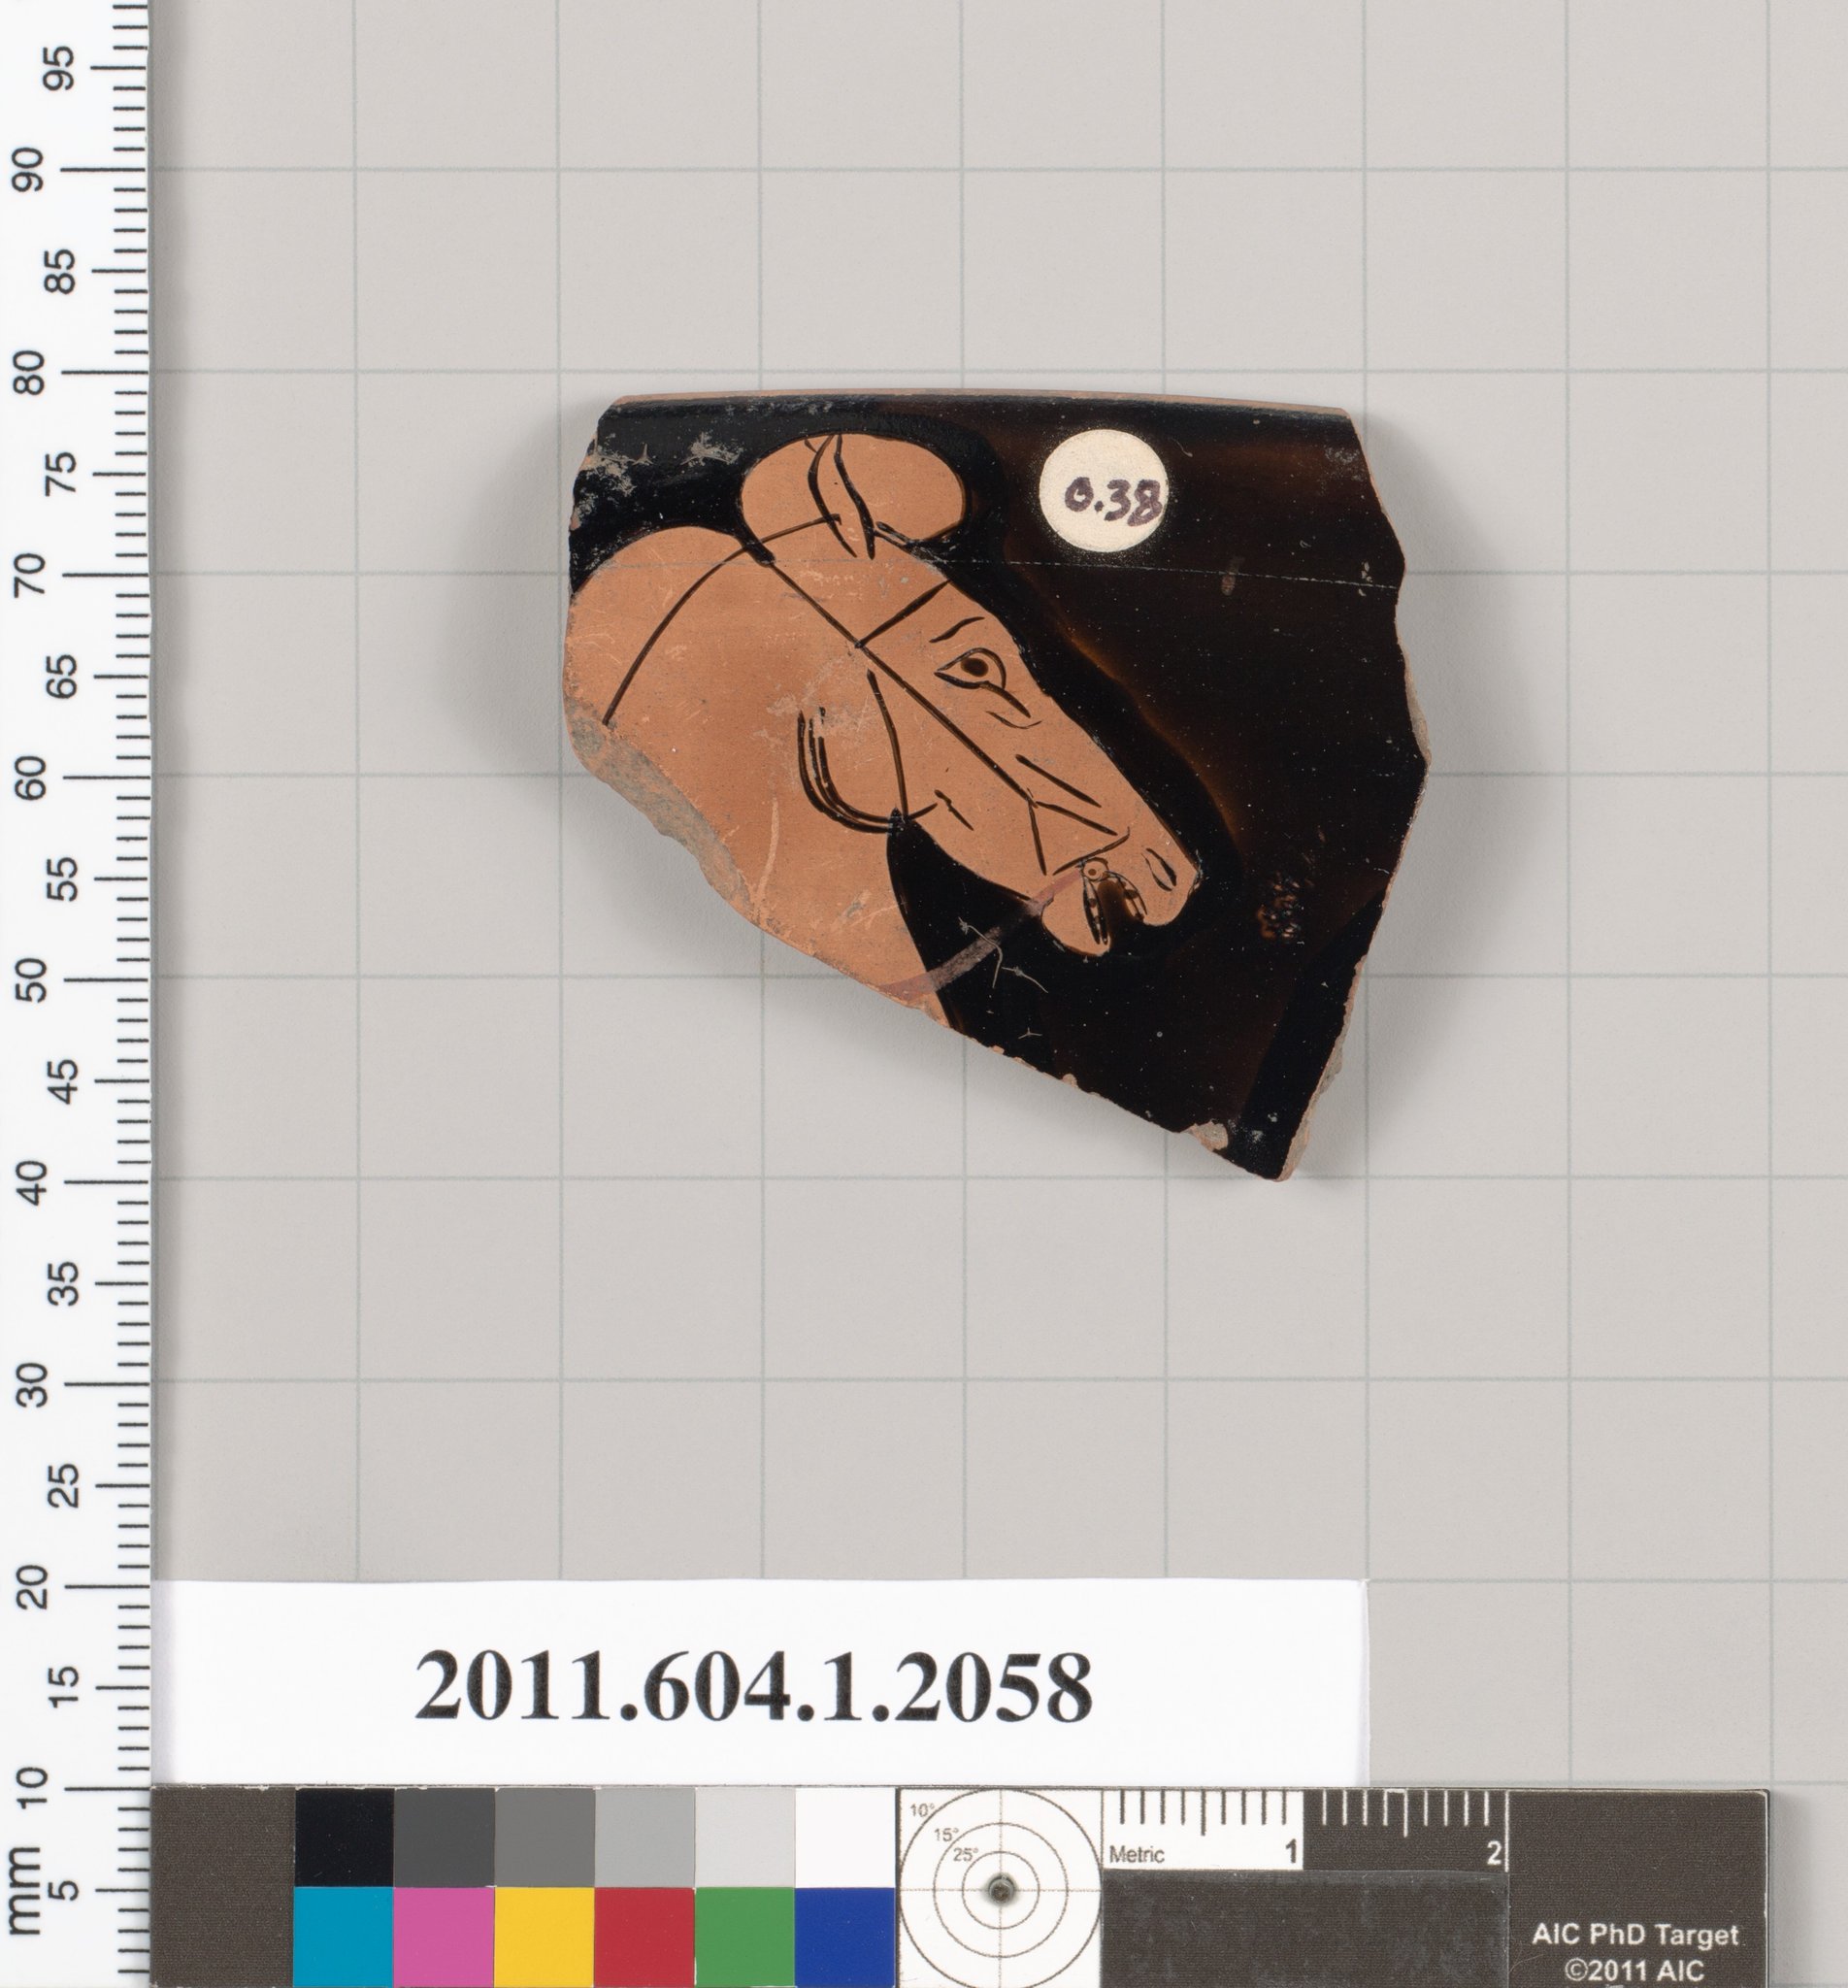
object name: kylix fragment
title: Terracotta rim fragment of a kylix (drinking cup)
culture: greek, attic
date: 490-480 BCE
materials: terracotta